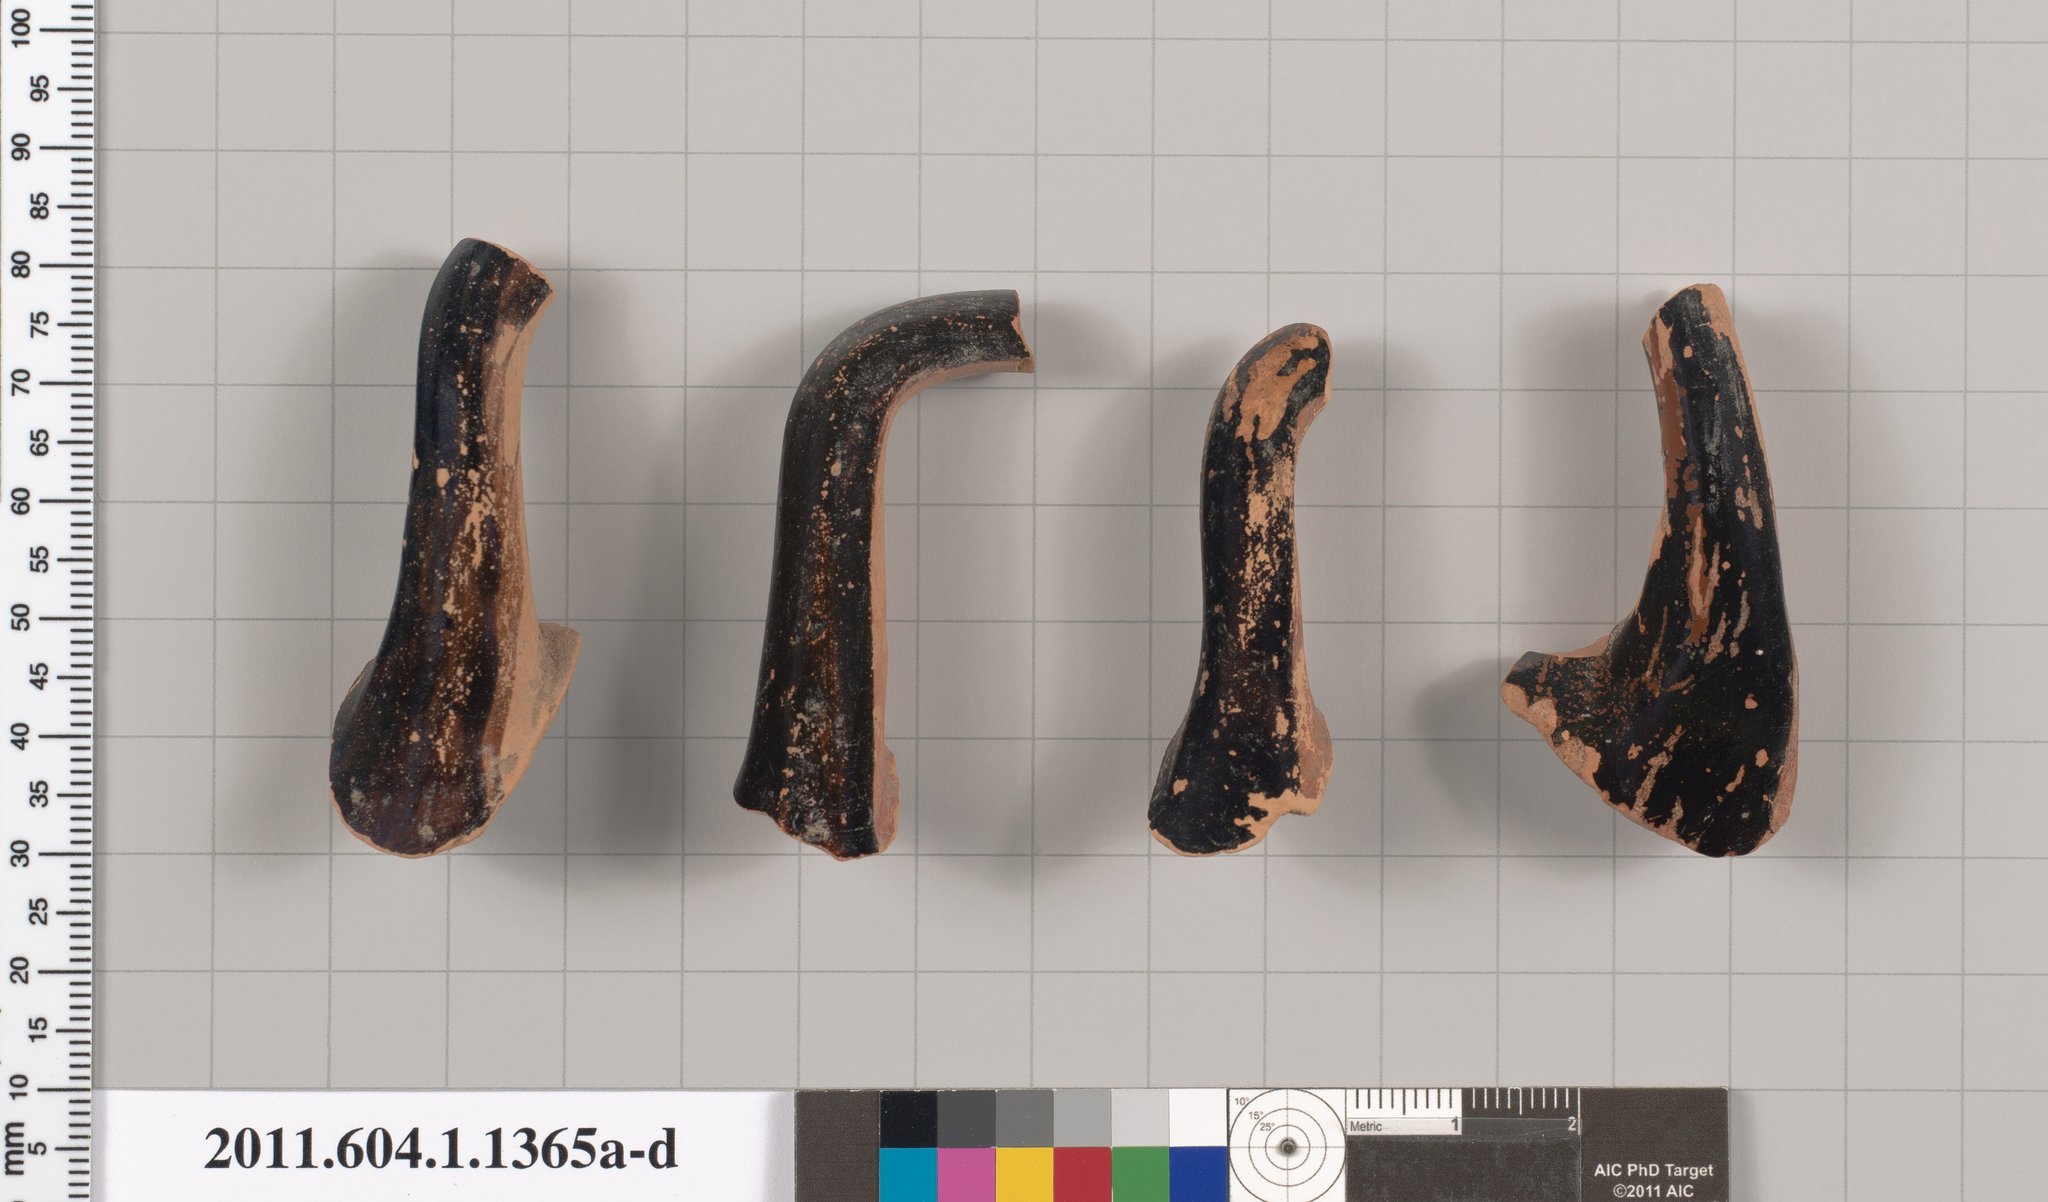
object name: kylix fragment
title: Terracotta fragments of kylikes (drinking cups)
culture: greek, attic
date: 500-401 BCE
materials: terracotta